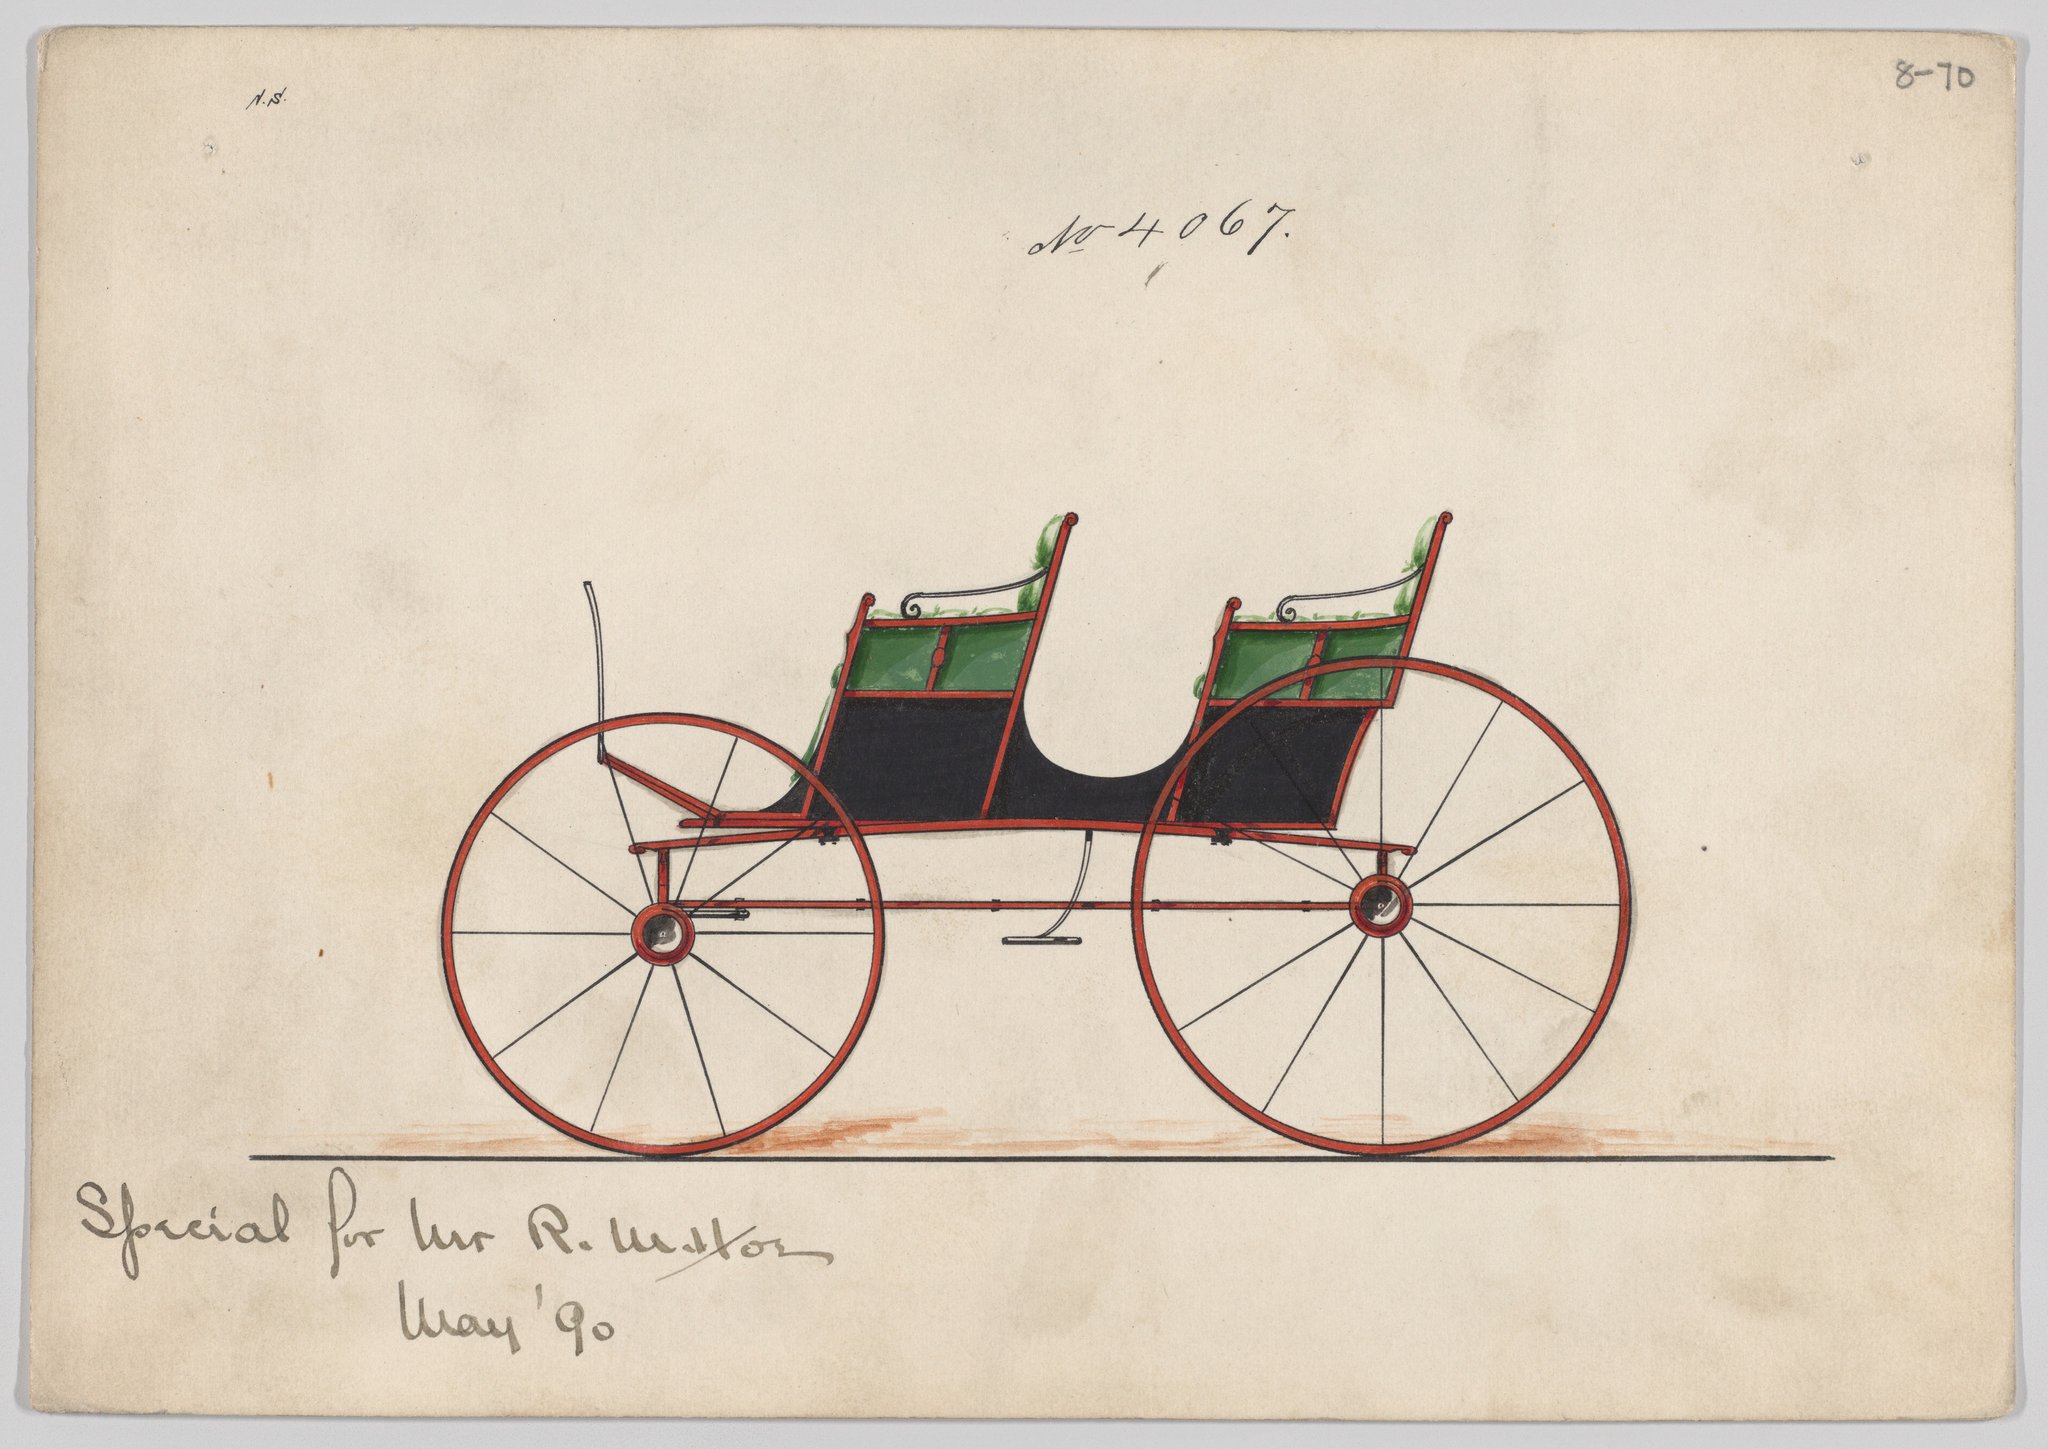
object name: drawing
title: Design for 4 seat Phaeton, no top, no. 4067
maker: brewster & co.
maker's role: manufacturer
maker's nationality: american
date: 1890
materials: gouache, gum arabic, ink, watercolor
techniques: pen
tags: carriages